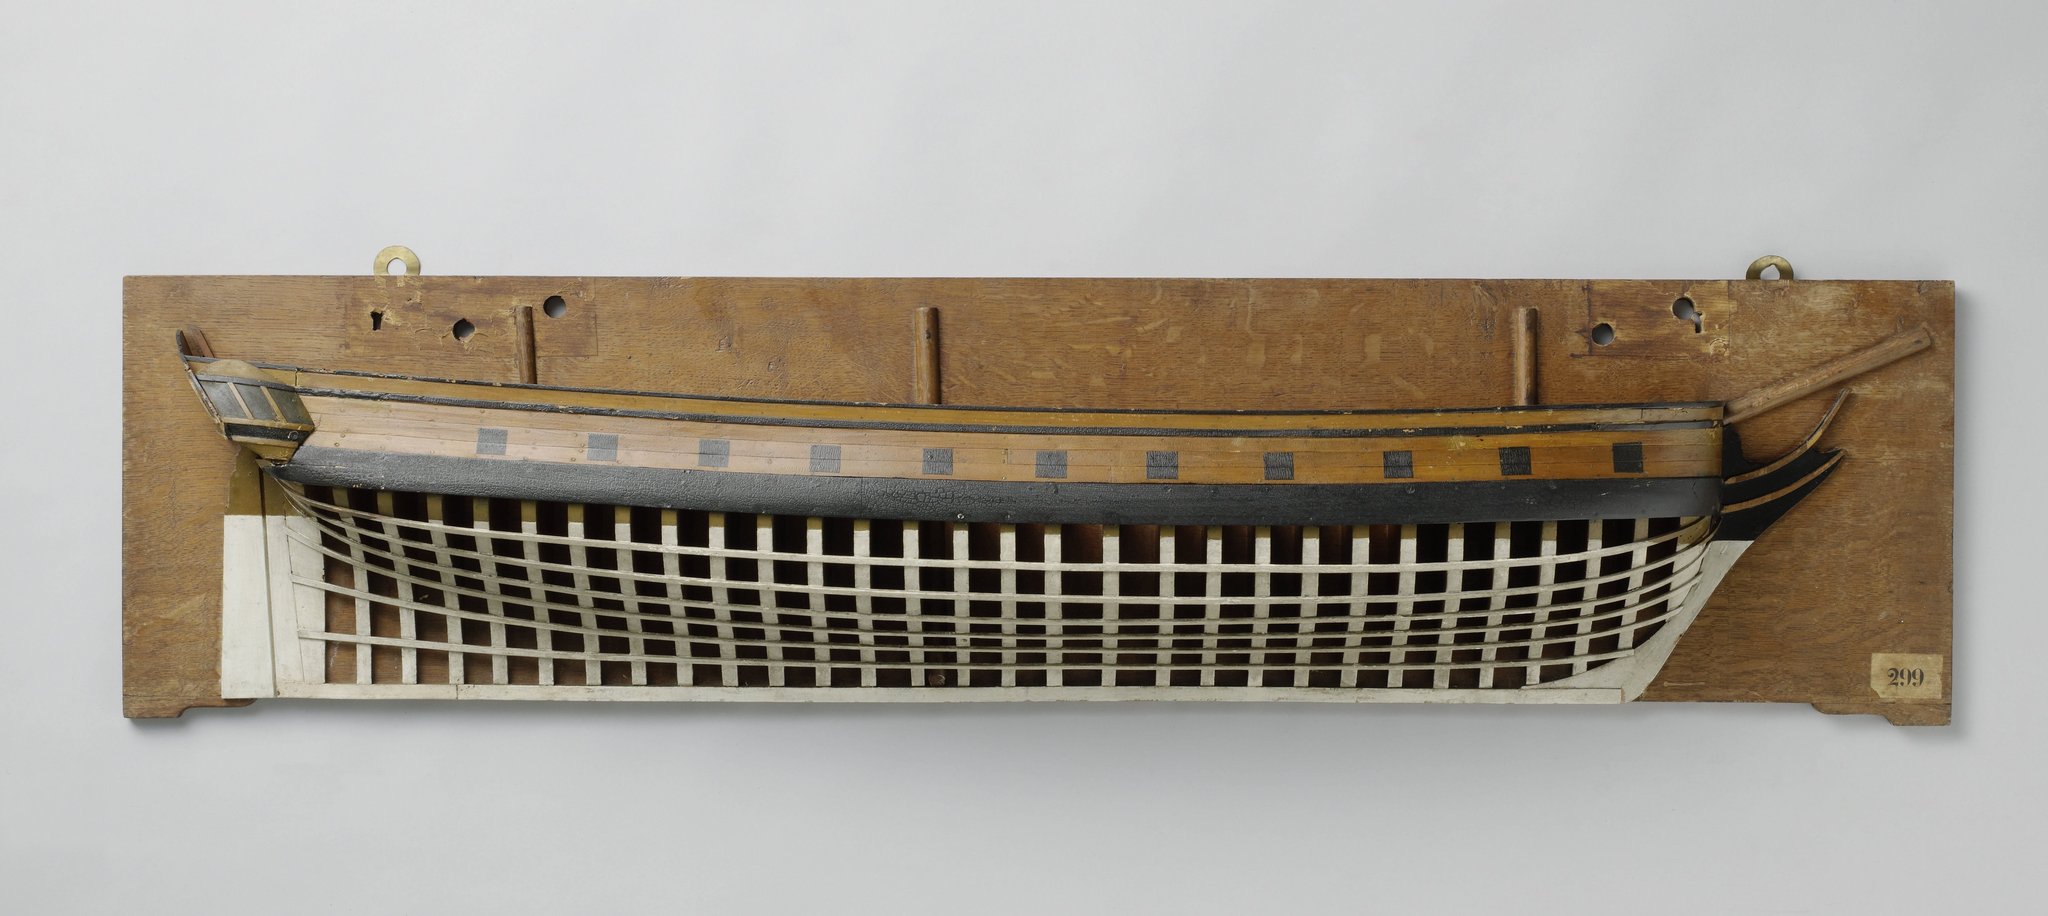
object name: ship model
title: Half Model of a 24-Gun Frigate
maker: Anonymous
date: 1790-1825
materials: wood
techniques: polychromy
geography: netherlands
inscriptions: label, bottom right: ‘299’ former inventory label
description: Gepolychromeerd mallenmodel (stuurboord) van een driemaster. Elf geschutpoorten op één geschutdek. Gewrongen spiegel, hol wulf, hek en zijgalerij van één verdieping; recht roer met vierkante roerkoning. Zeeg aan beide uiteinden iets oplopend, één berghout en één reehout. Gepiekt rondspant.